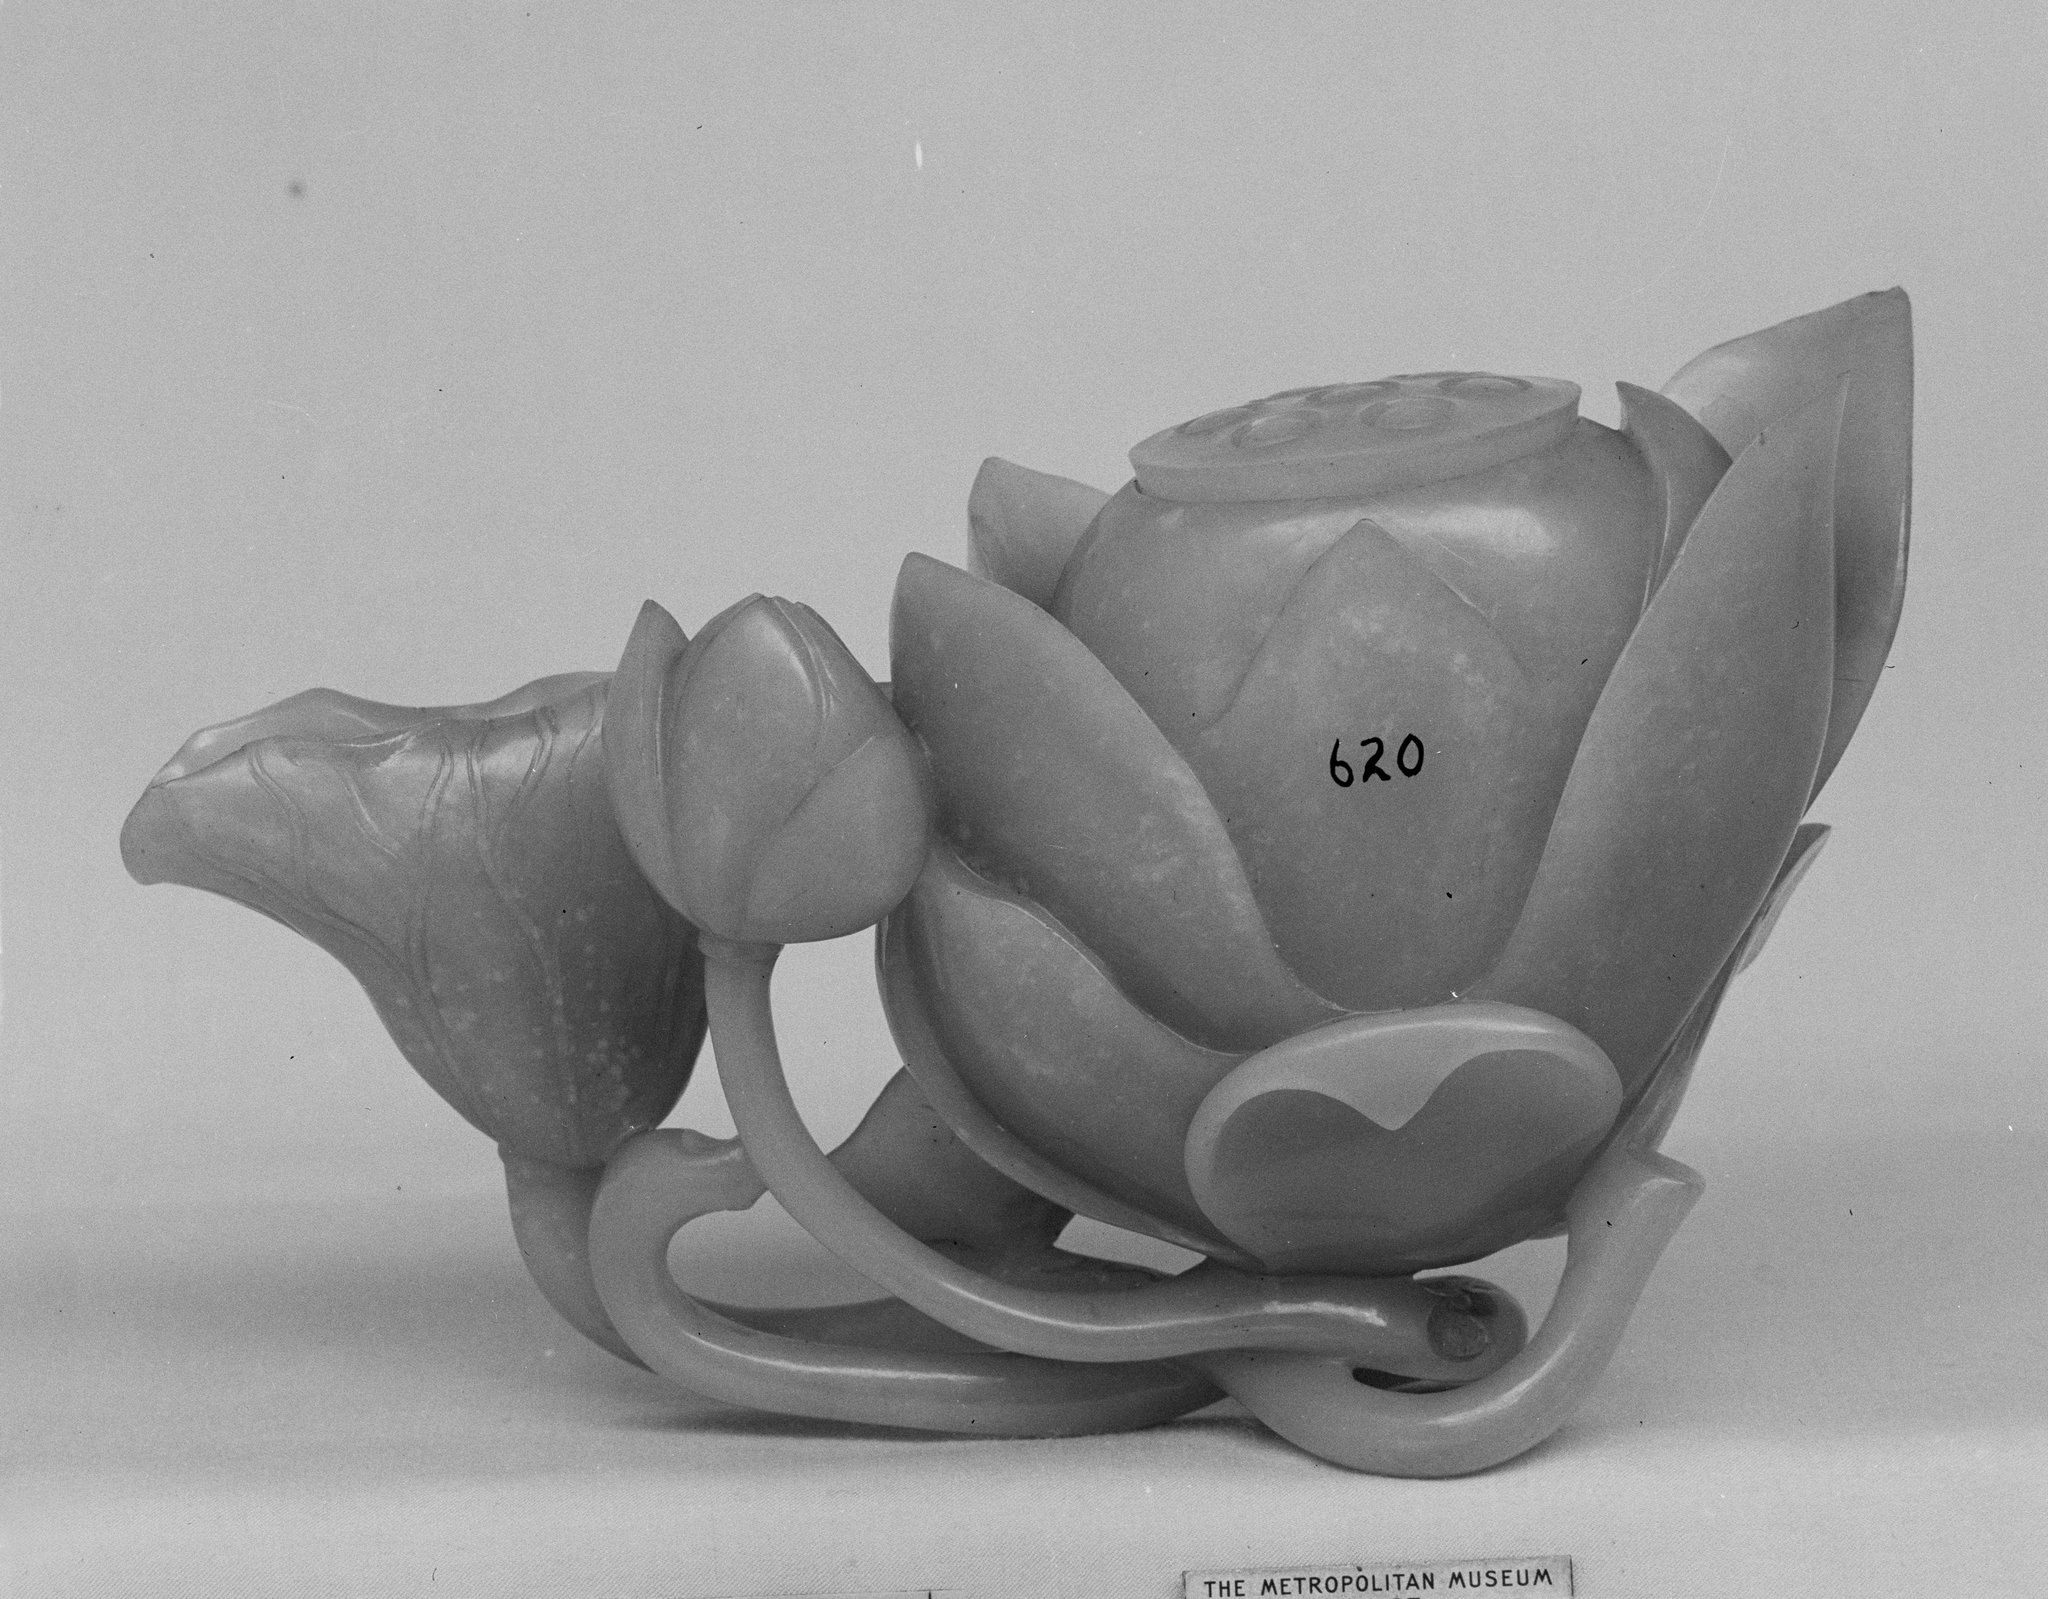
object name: water receptacle with cover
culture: chinese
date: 1736-1795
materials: jade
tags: flowers